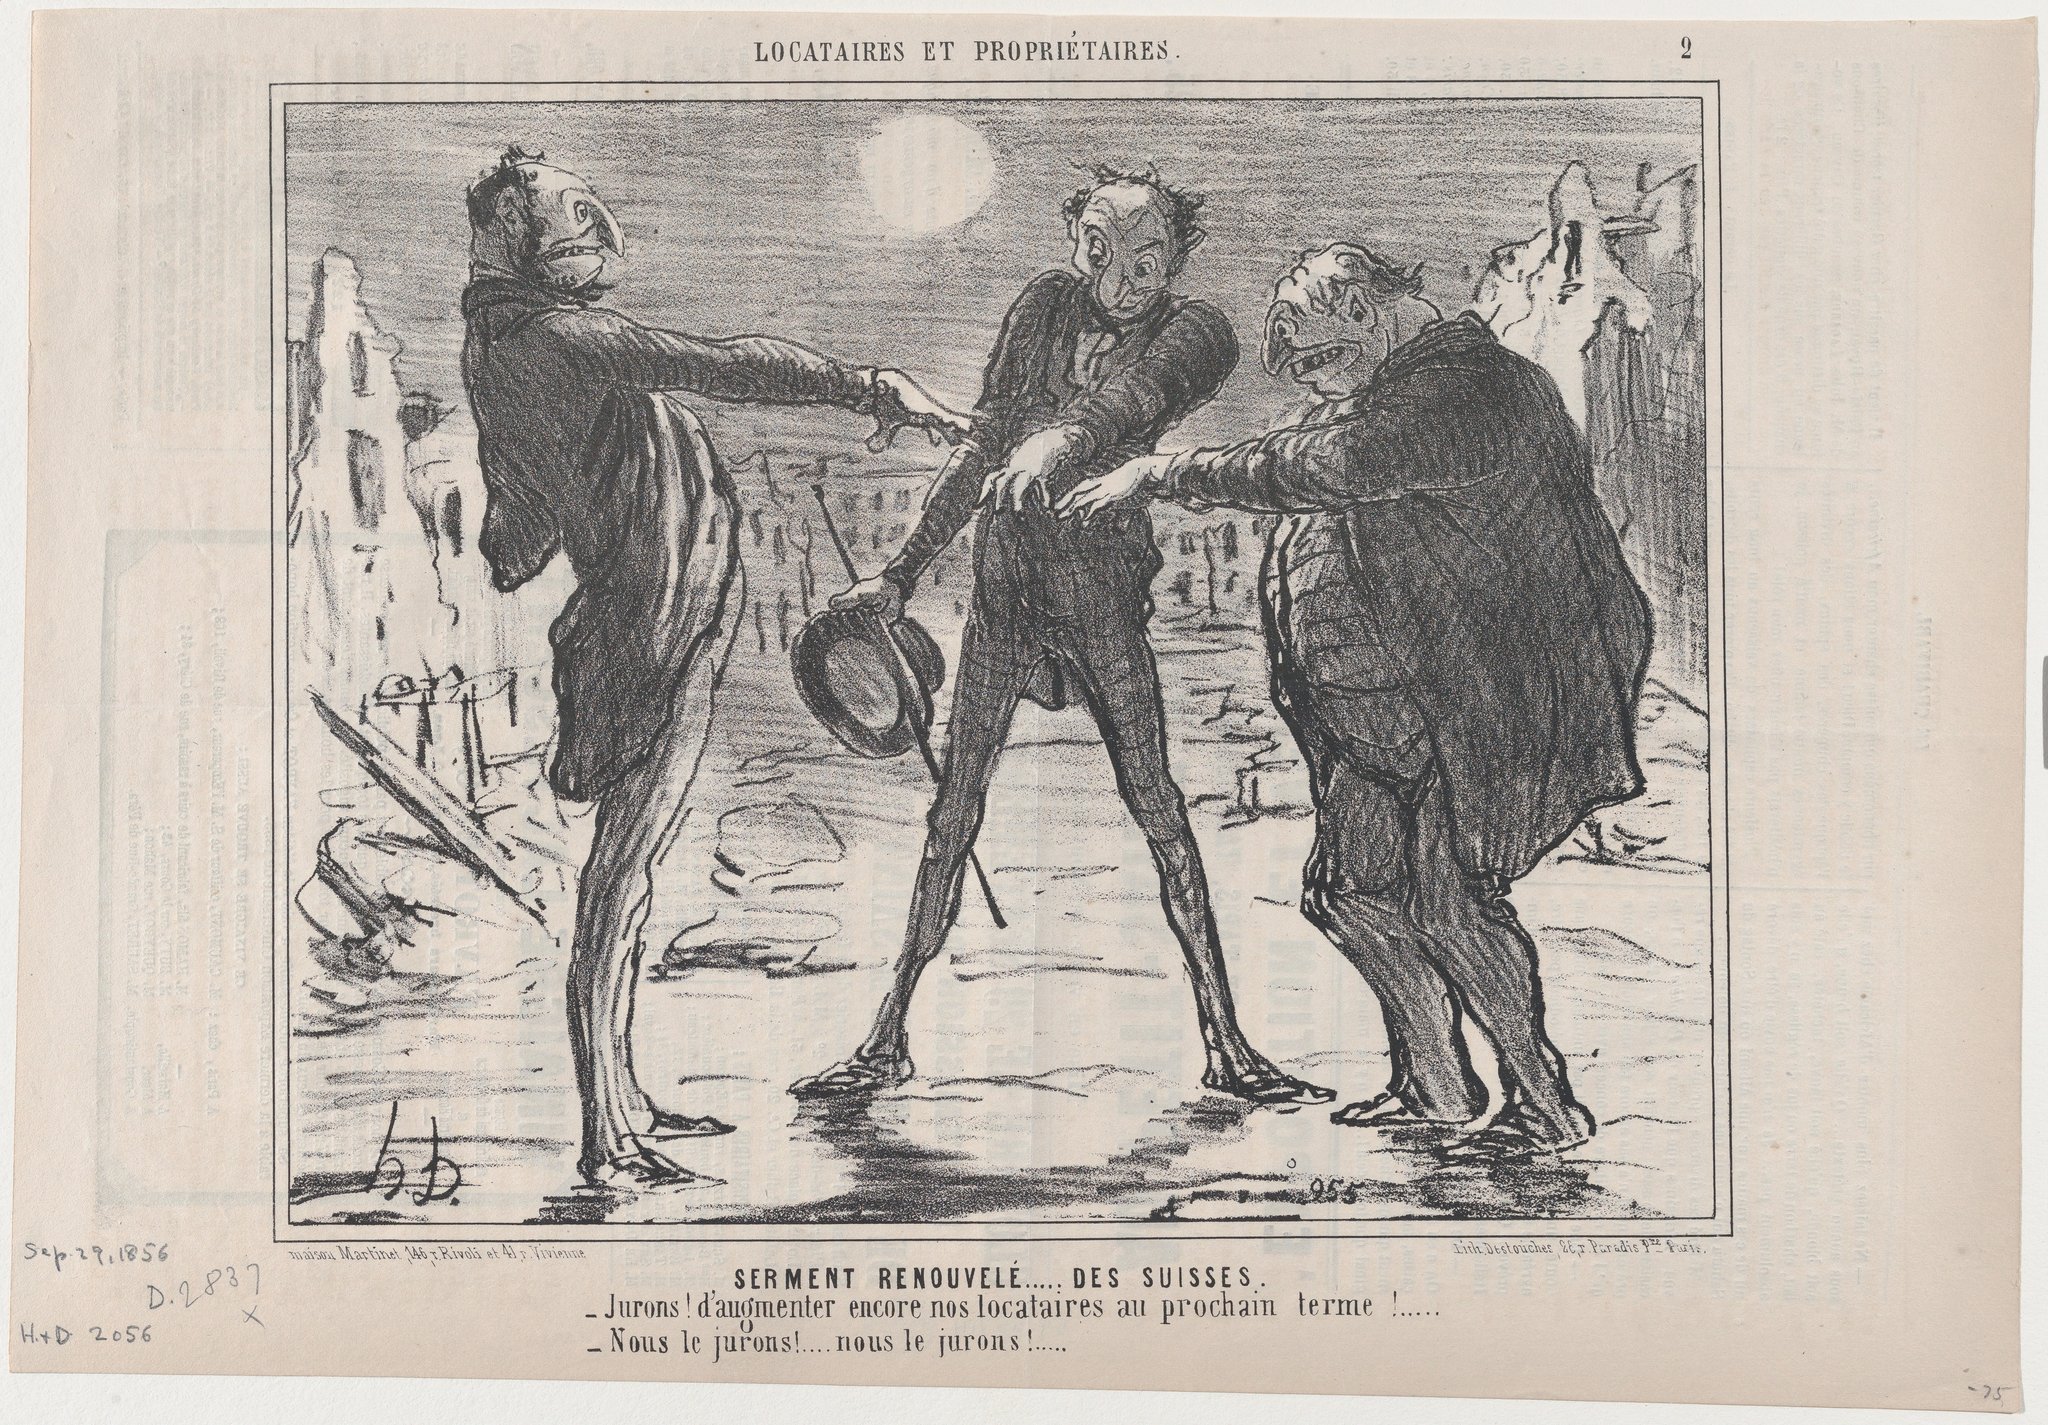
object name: print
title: Serment Renouvelé...des Suisses, from Locataires et Propriétaires, published in Le Charivari, September 29, 1856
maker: honoré daumier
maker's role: artist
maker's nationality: french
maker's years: 1808-1879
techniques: lithograph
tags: satire,men